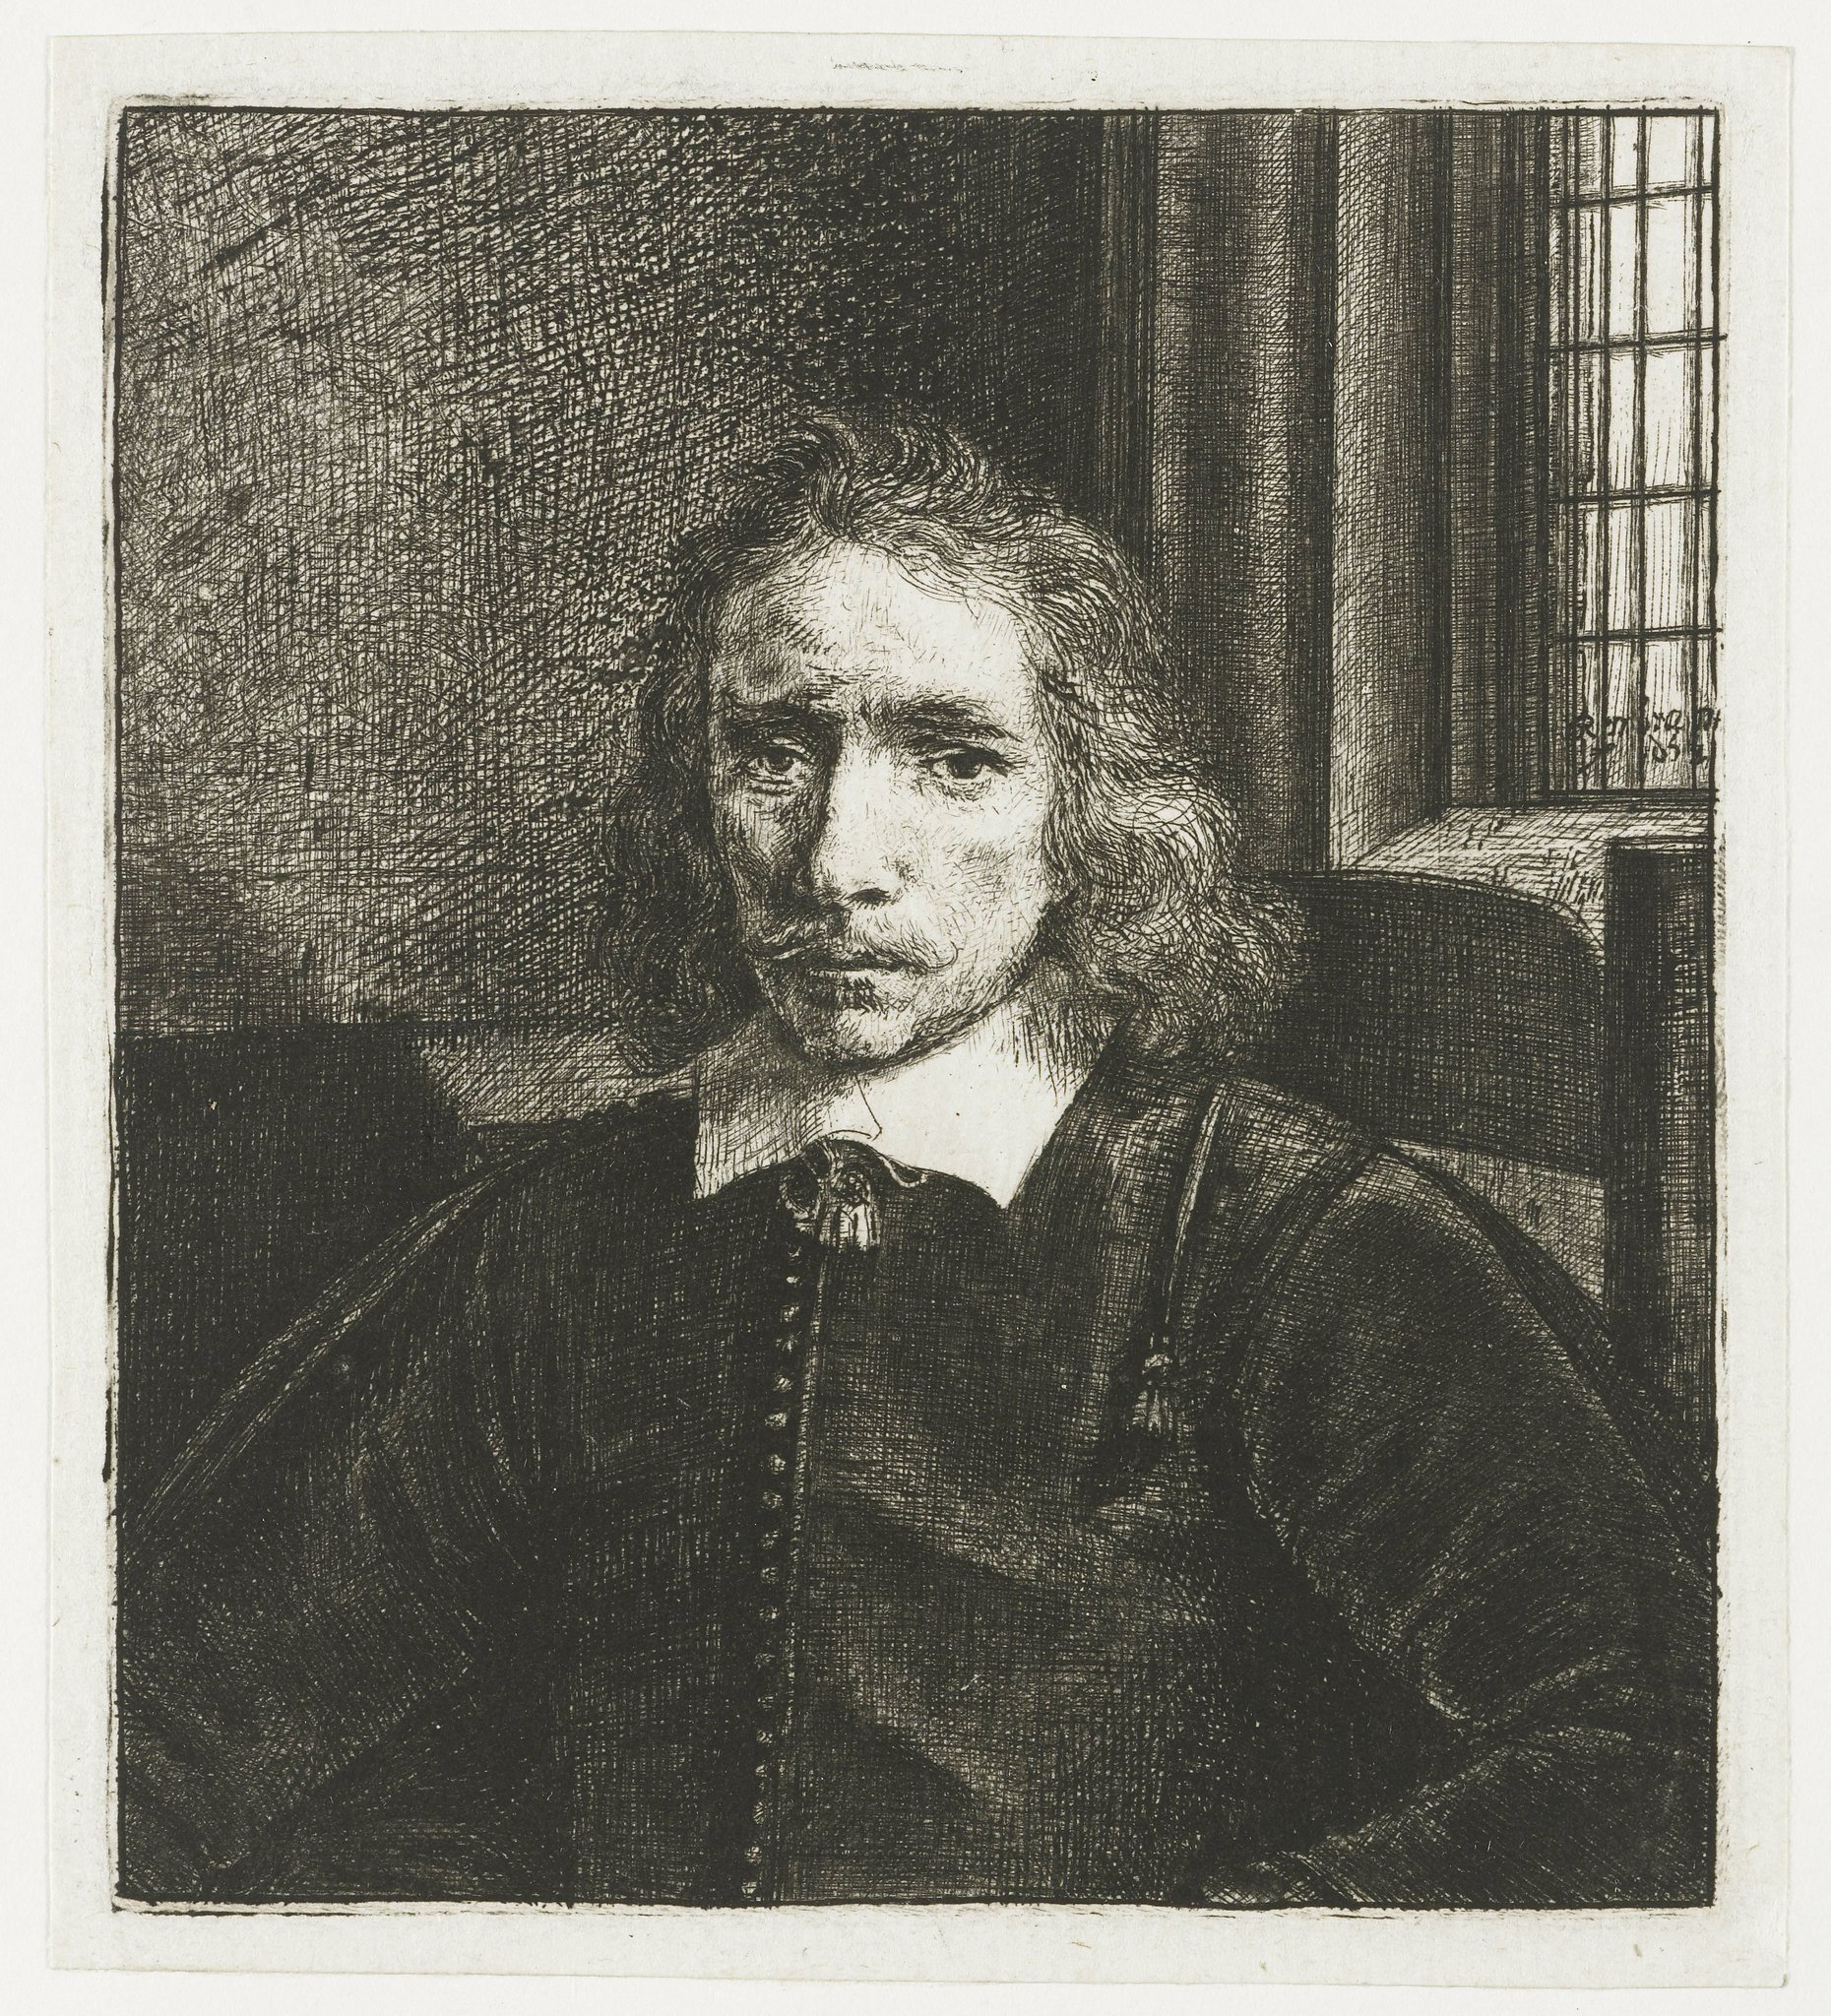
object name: print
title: Pieter Haaringh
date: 1655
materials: paper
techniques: drypoint, etching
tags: pieter haringh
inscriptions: collector's mark: Lugt 240, signature and date: ‘Rembrandt f 1655’